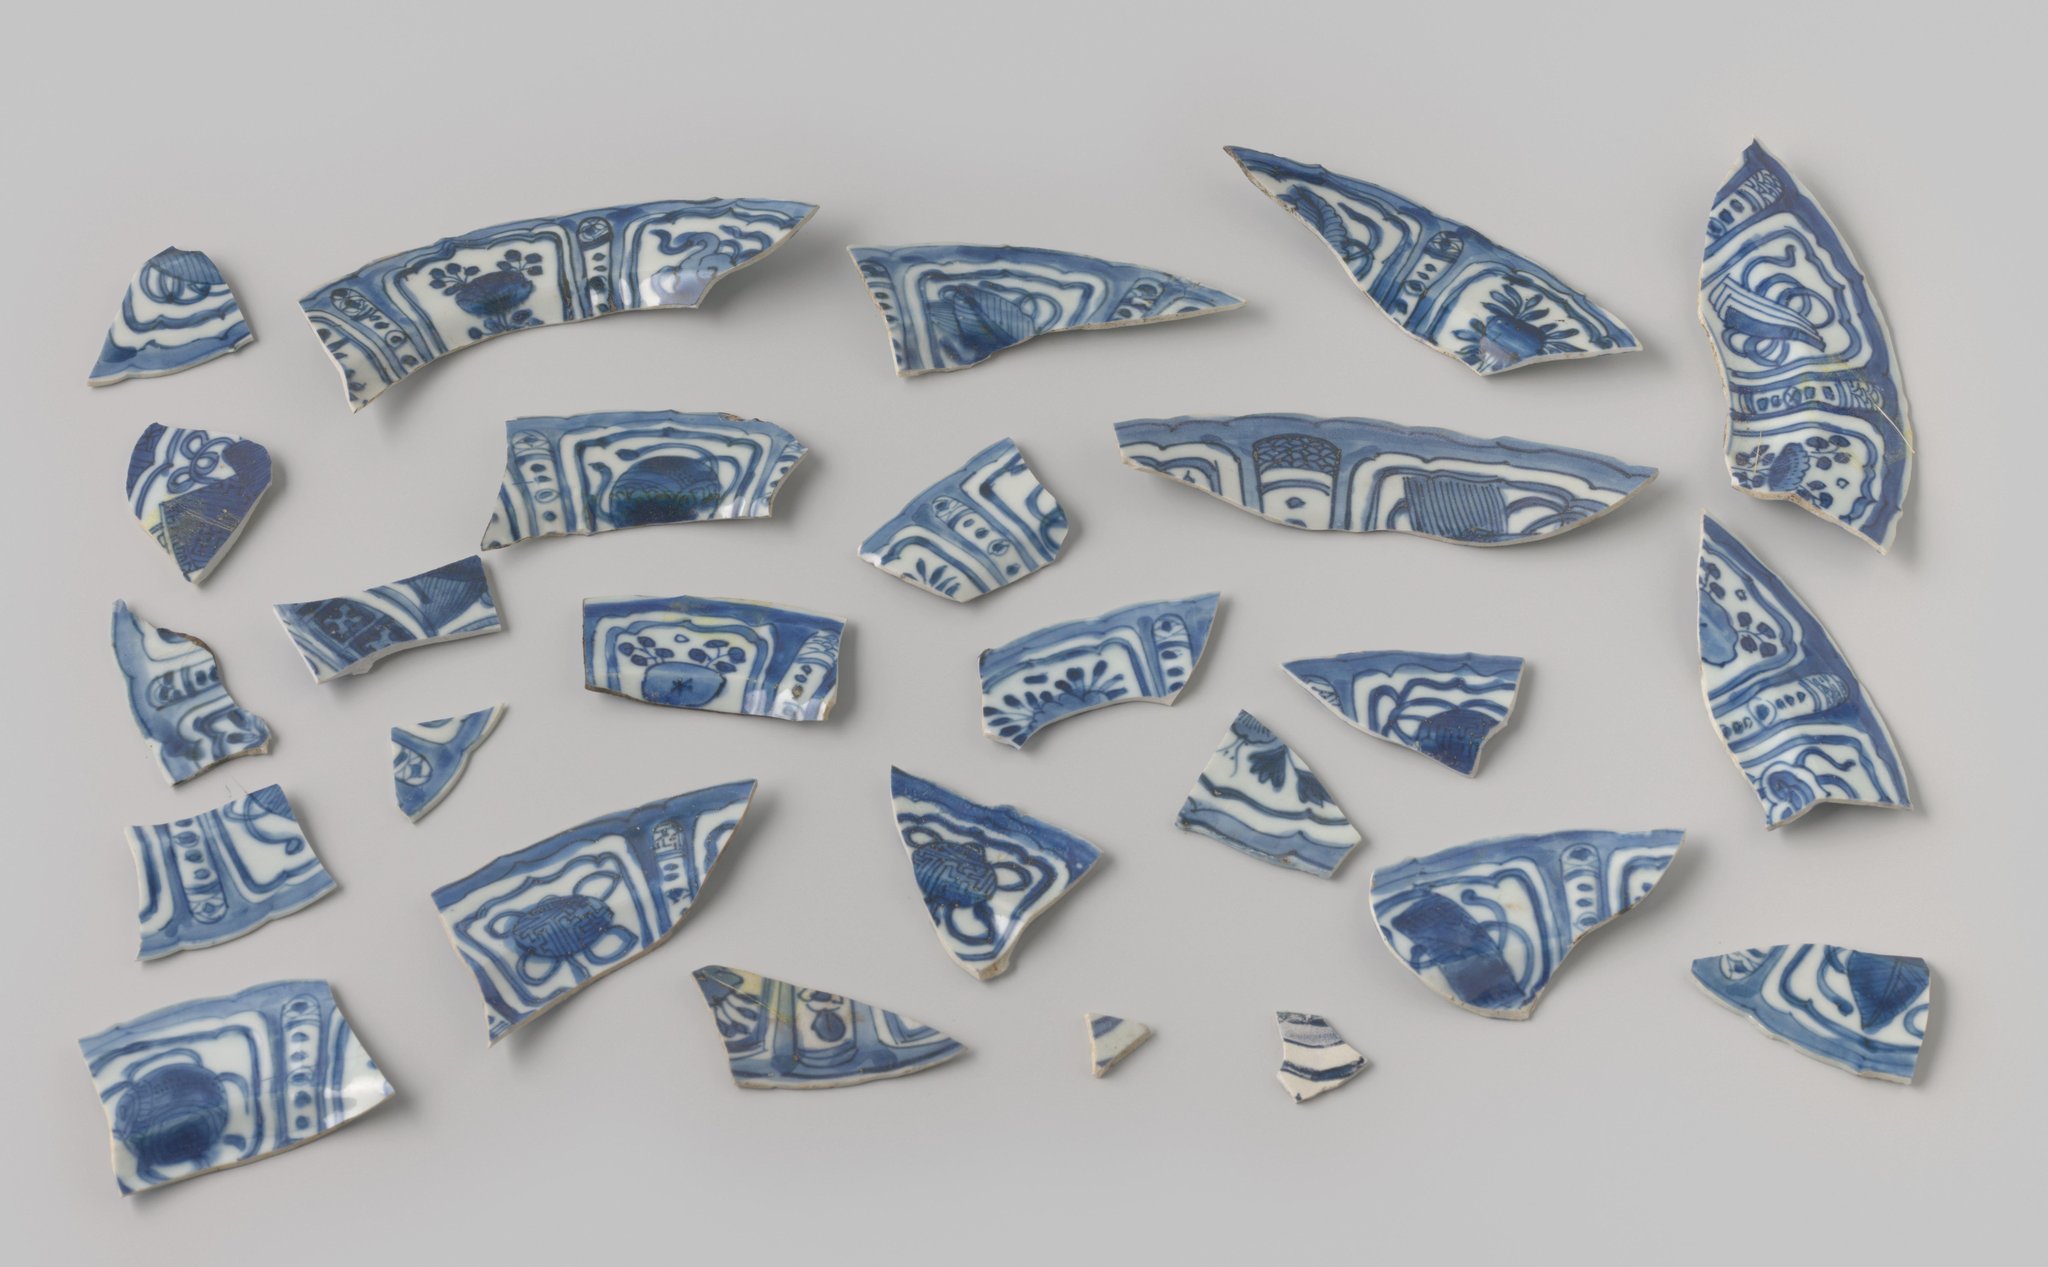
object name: plate dish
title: Porseleinen scherven uit V.O.C.-schip de 'Witte Leeuw'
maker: Anonymous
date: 1613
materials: bone china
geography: jingdezhen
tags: verenigde oostindische compagnie, sint-helena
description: Porseleinen scherven van borden uit V.O.C.-schip de 'Witte Leeuw'.